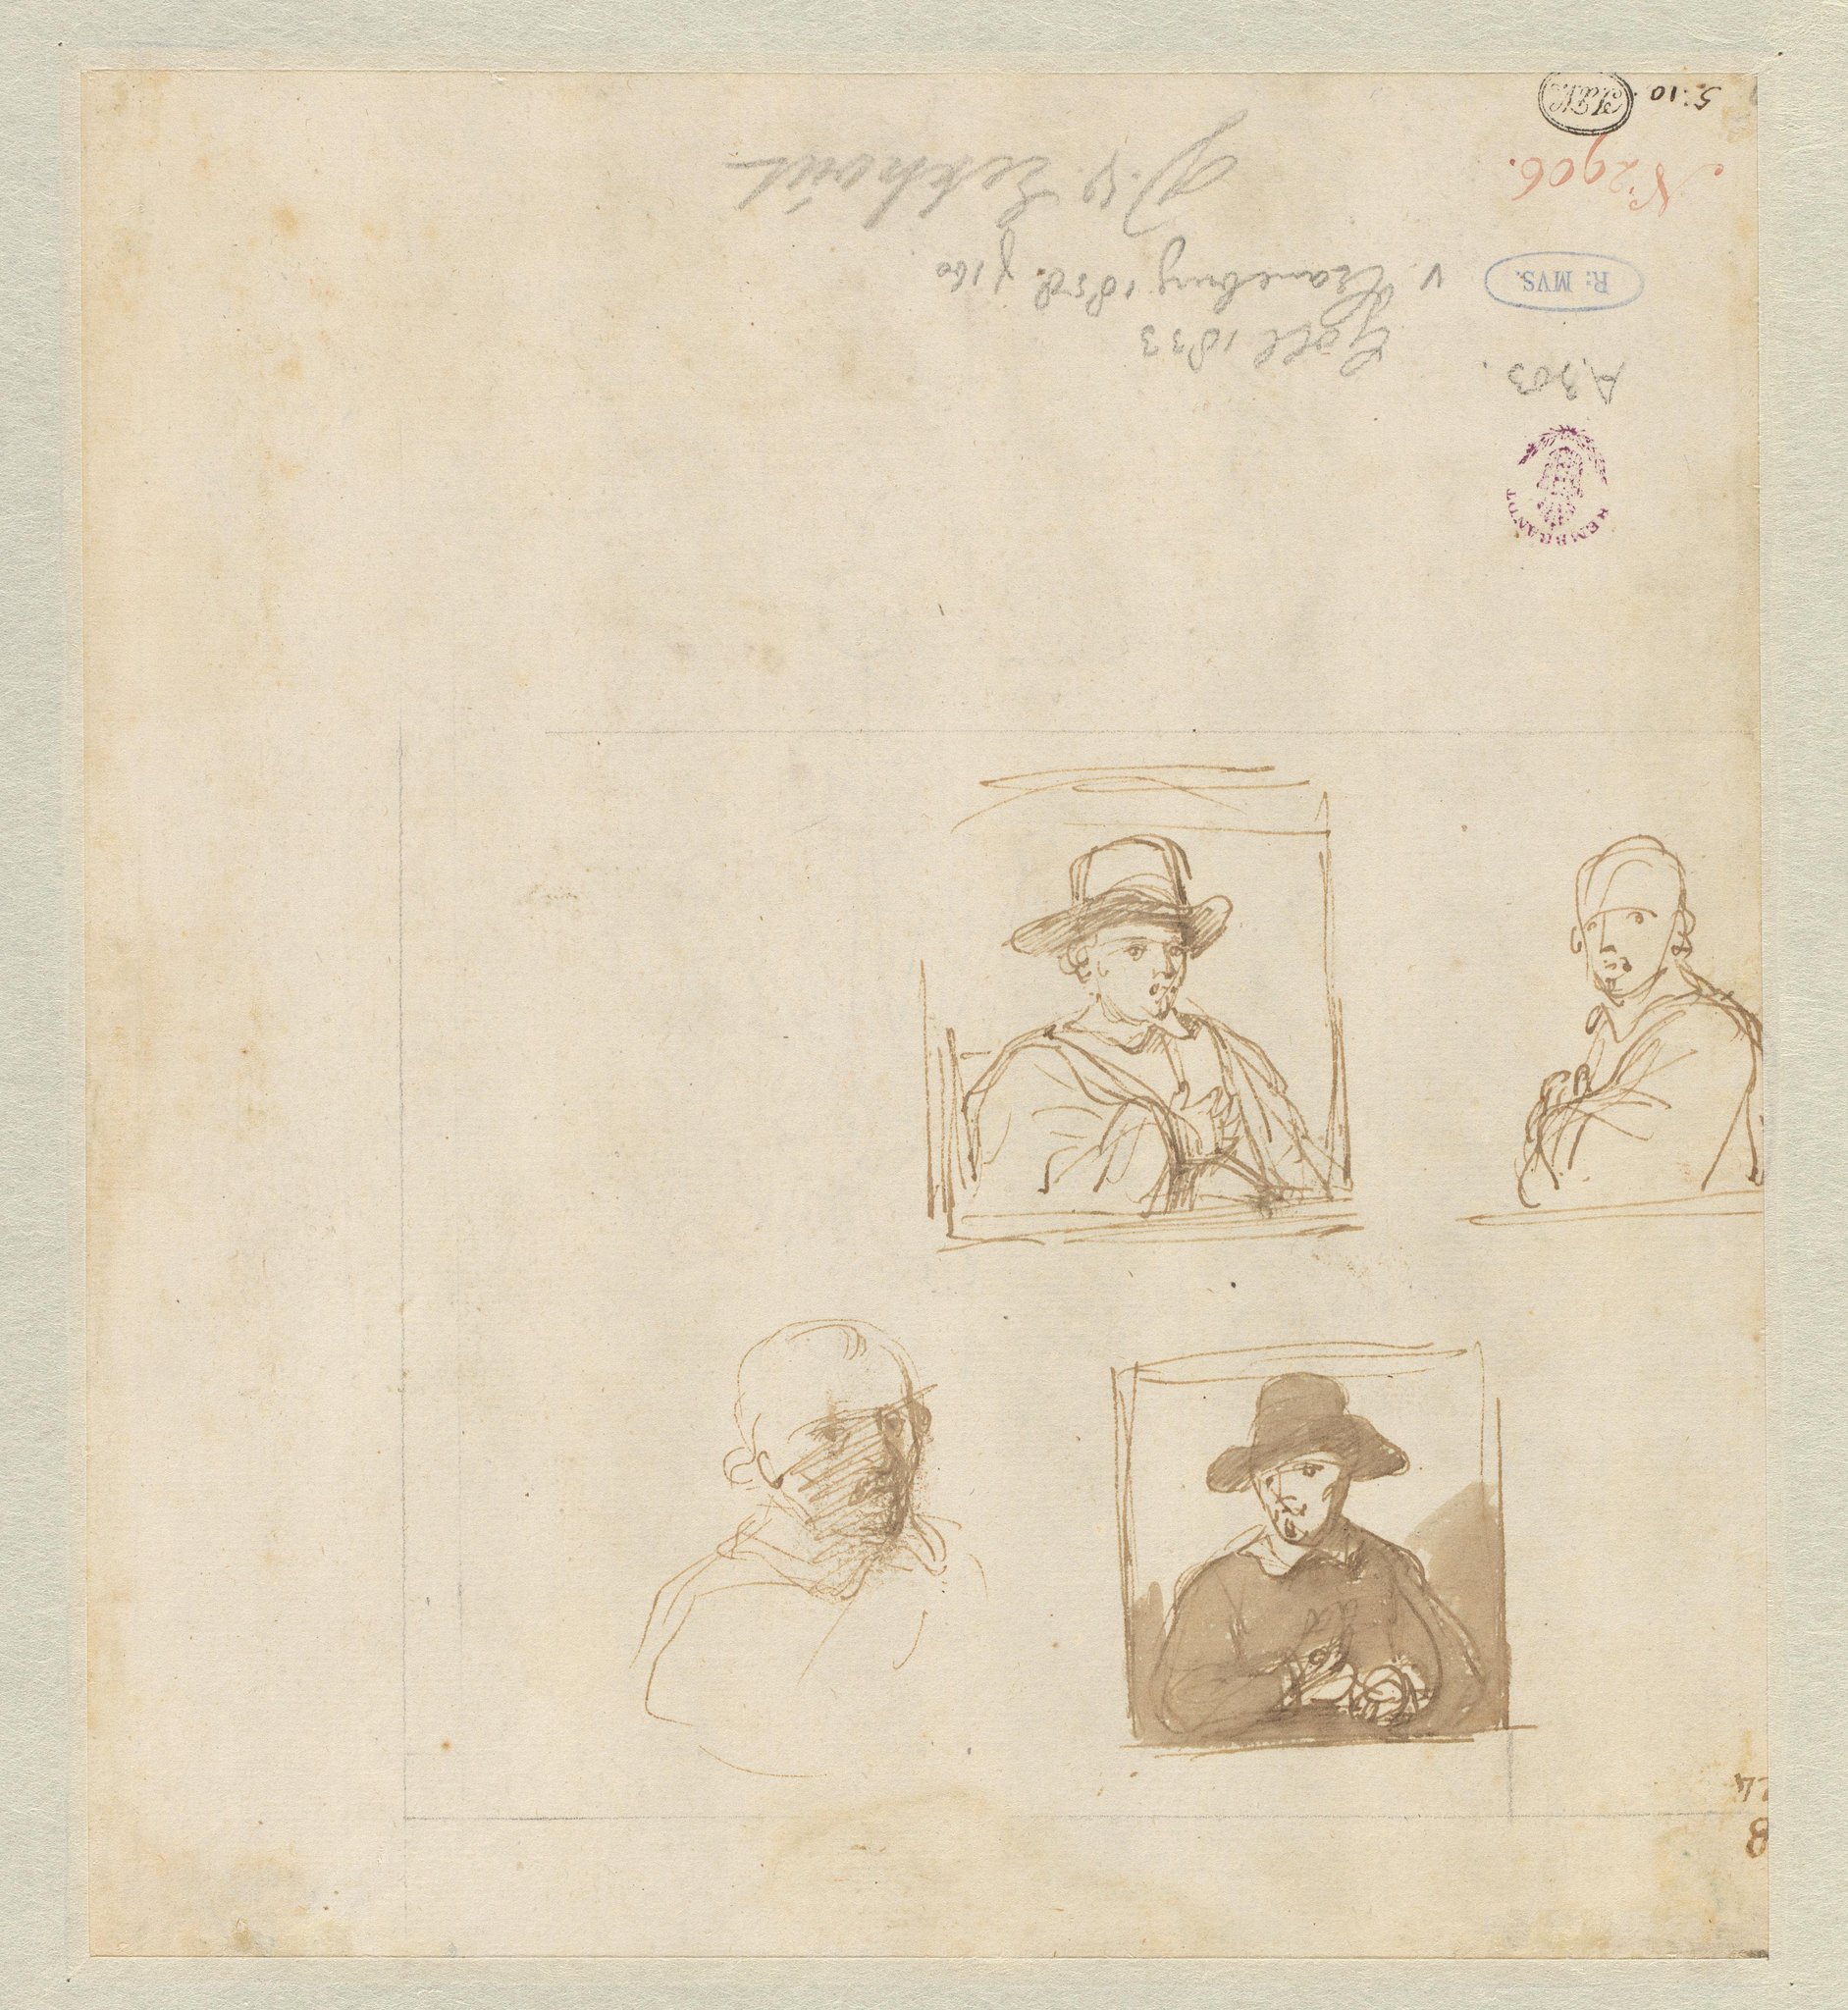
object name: drawing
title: Four Studies for a Portrait of a Man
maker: gerbrand van den eeckhout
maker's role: draughtsman, print maker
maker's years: 1621-1674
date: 1648-1653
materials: ink, paper, pencil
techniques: brush, pen